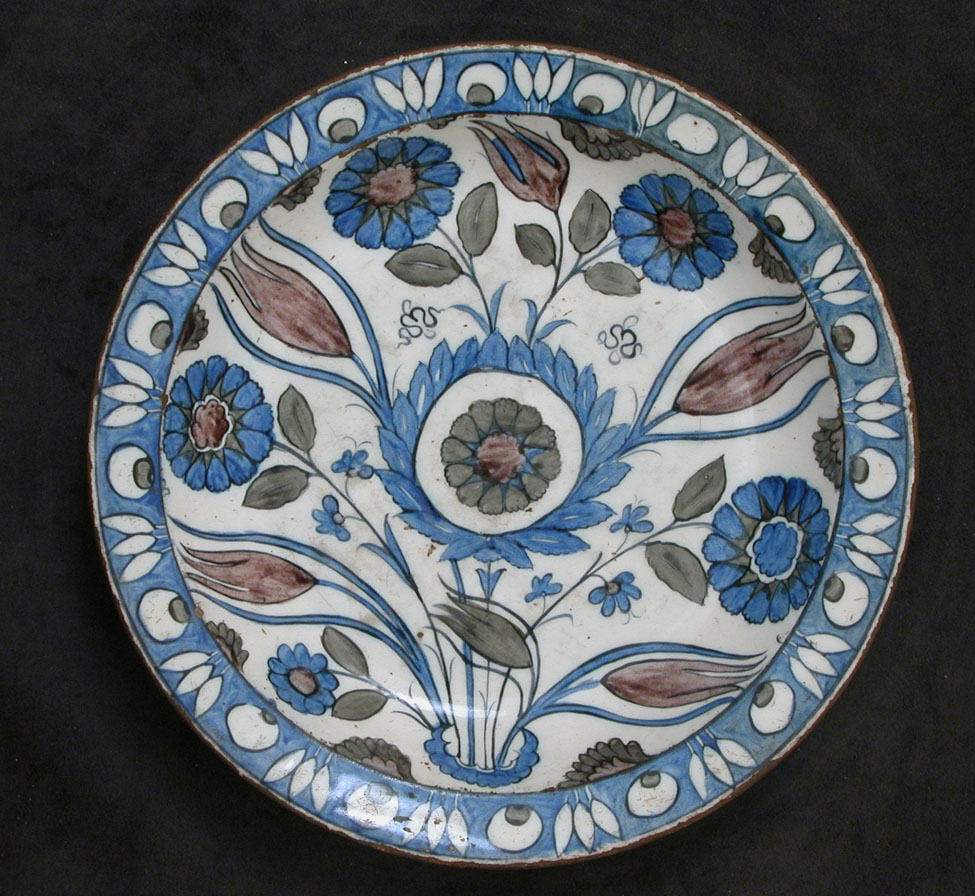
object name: dish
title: Dish with Floral Design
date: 1551-1600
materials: glaze, stonepaste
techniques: painting, polychrome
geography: turkey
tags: flowers